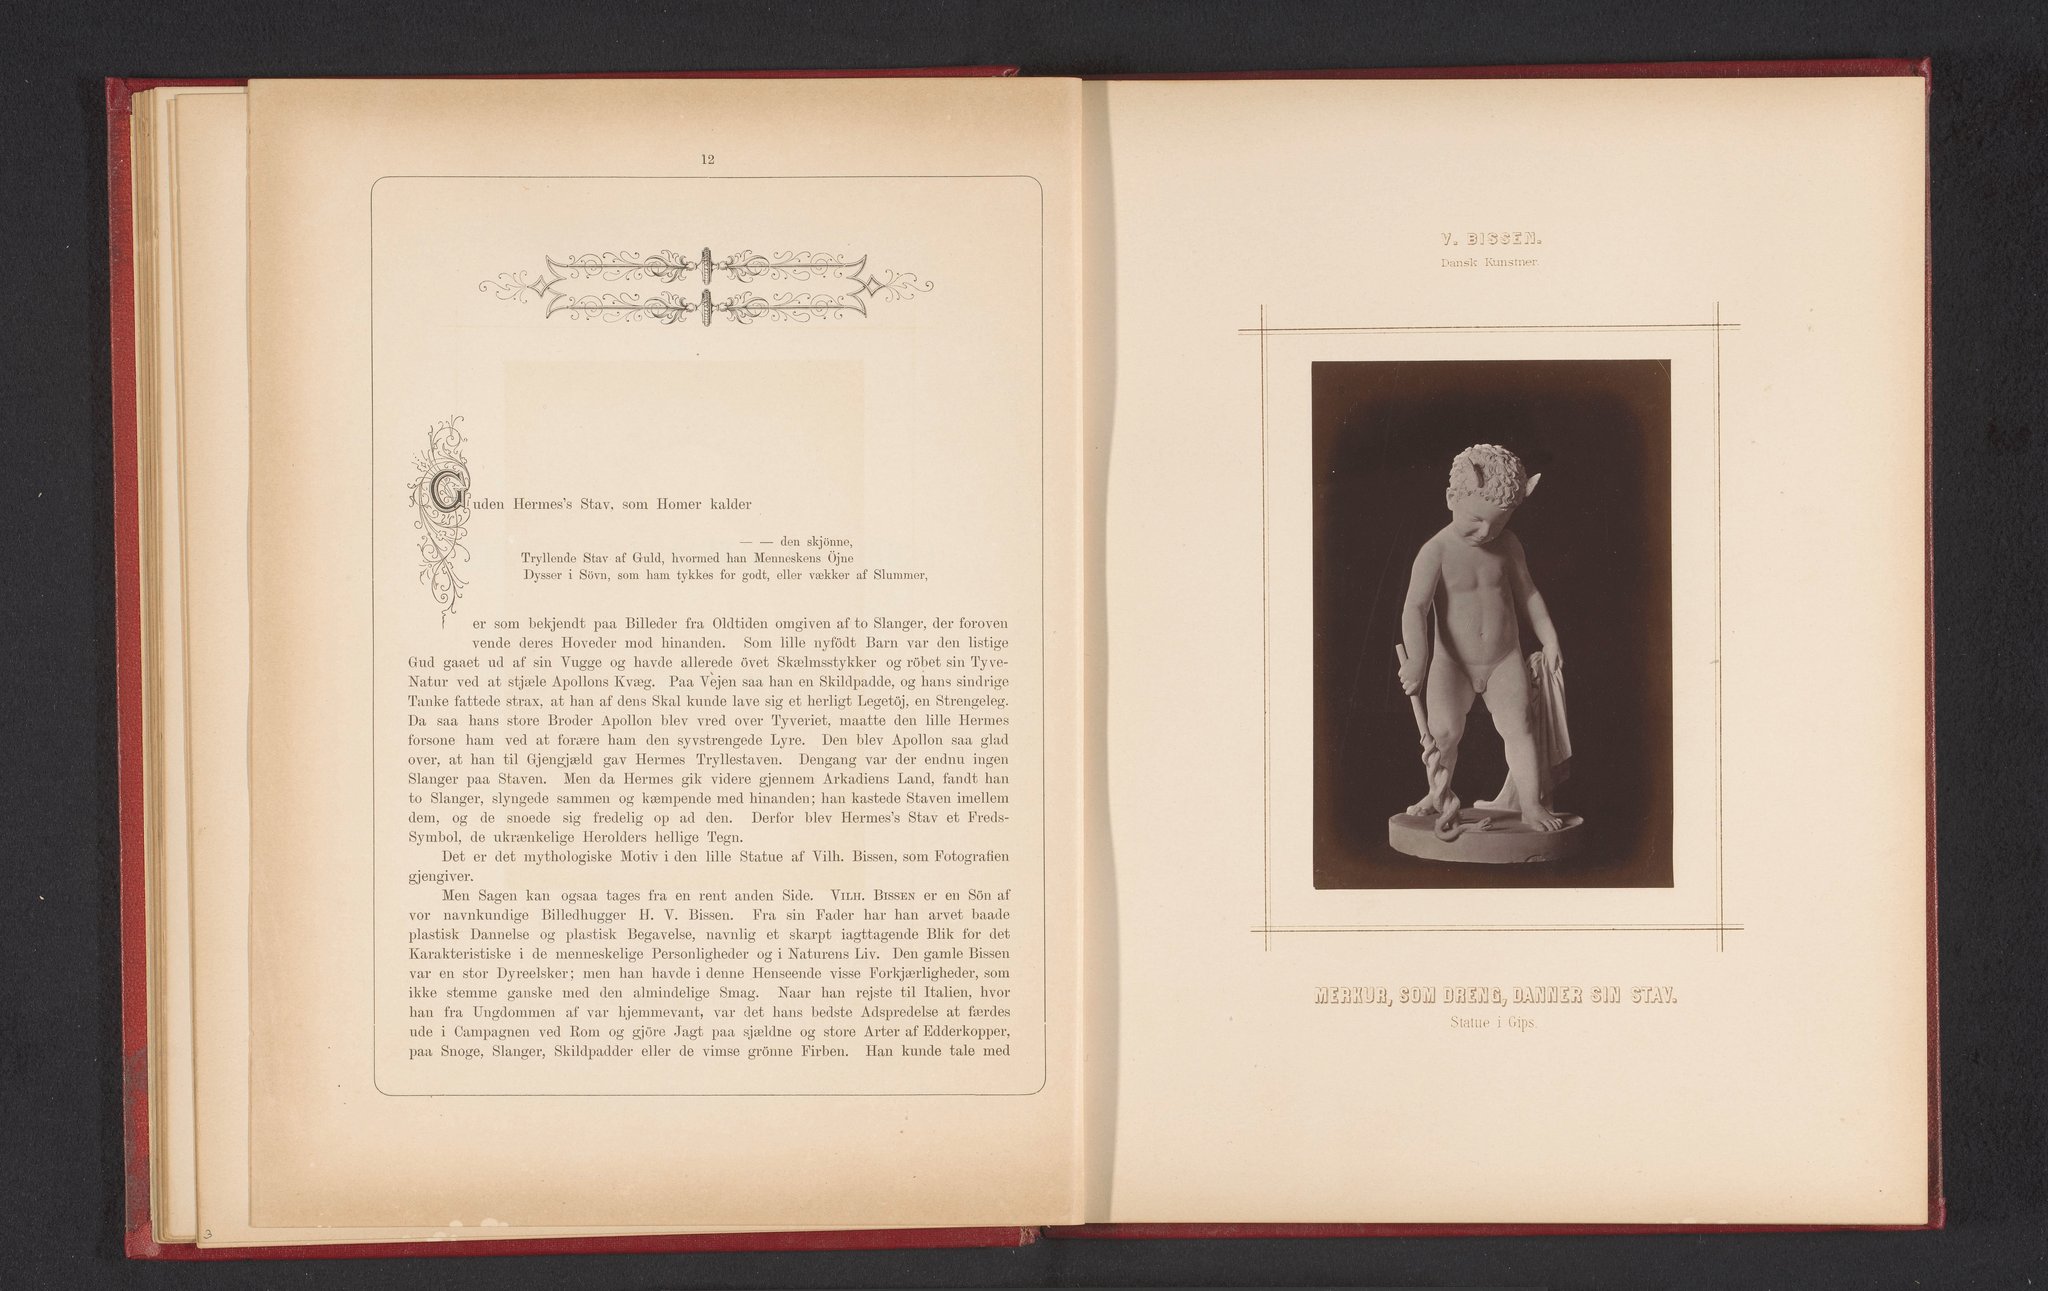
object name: photograph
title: Merkur, Som Dreng, Danner Sin Stav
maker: johannes jaeger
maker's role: fotograaf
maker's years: 1832-1908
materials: photographic support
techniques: albumen print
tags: toddler (male), piece of sculpture, reproduction of a piece of sculpture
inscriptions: inscription: ‘Statue i Gips.’, inscription: ‘Dansk Kunstner.’